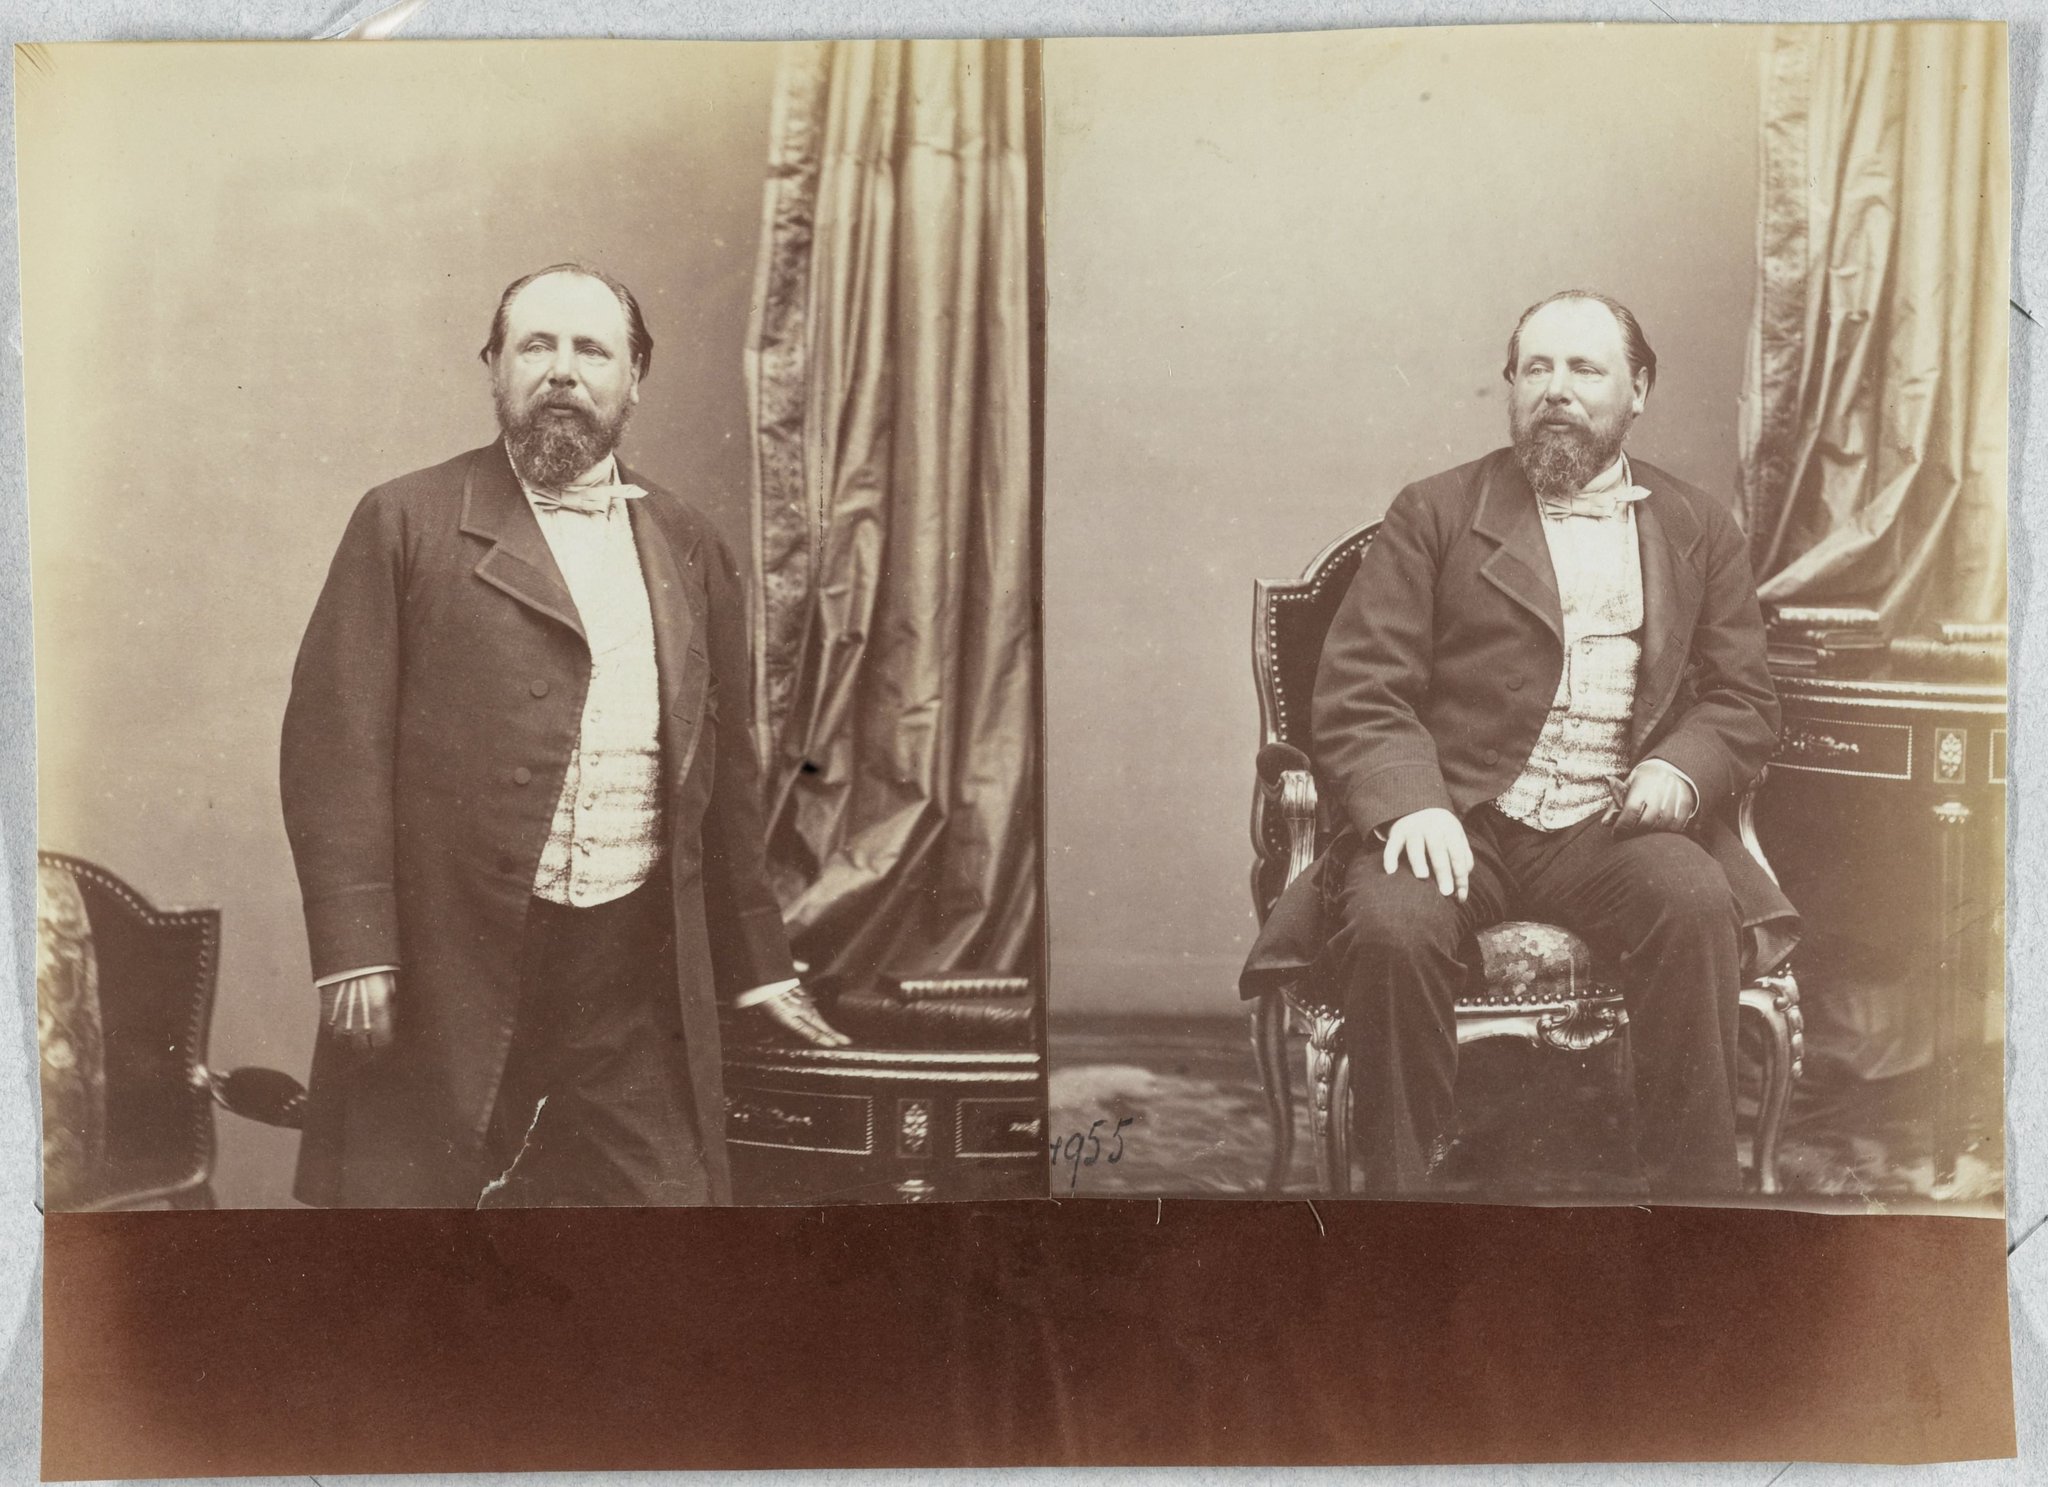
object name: photograph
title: Twee portretten van koning Willem III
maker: andré-adolphe-eugène disdéri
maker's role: fotograaf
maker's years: 1819-1889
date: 1862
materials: paper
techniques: albumen print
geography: paris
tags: brussels, willem iii (koning der nederlanden), historical persons, king, paris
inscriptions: inscription: ‘Guillaume III/ Roi des Pays Bas’, number: ‘4955’